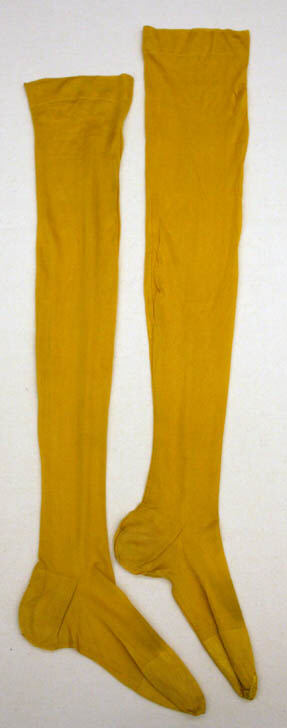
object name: stocking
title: Stockings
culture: american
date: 1897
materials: silk